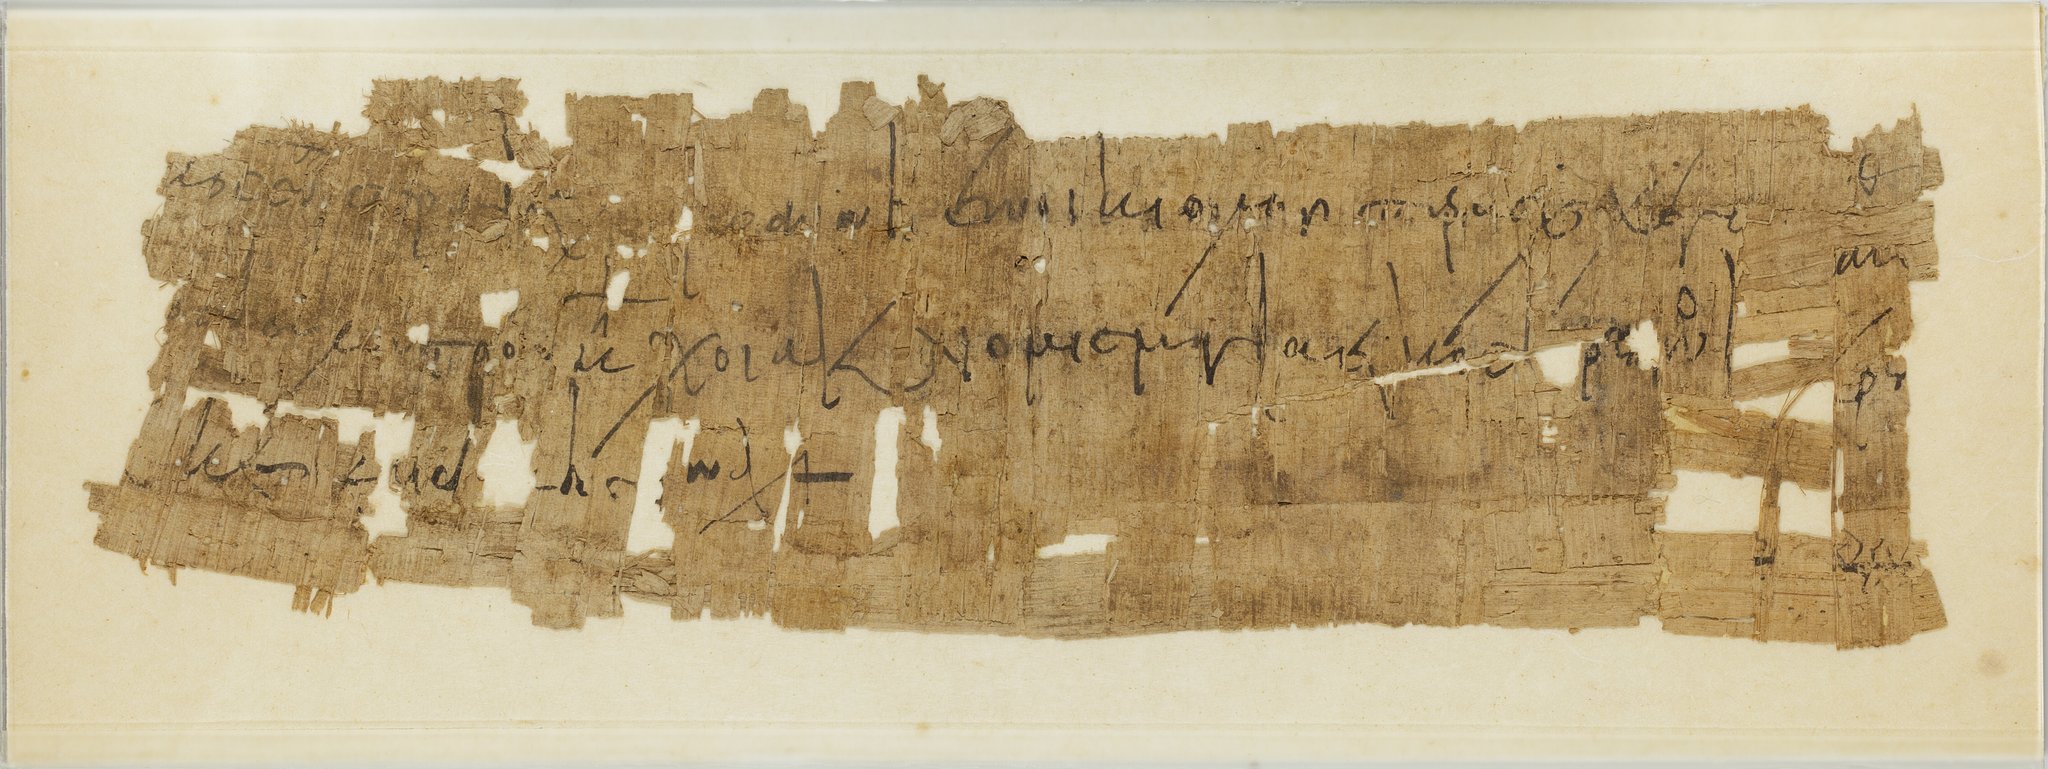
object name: papyrus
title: Papyrus fragment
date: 301-400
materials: ink, papyrus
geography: egypt